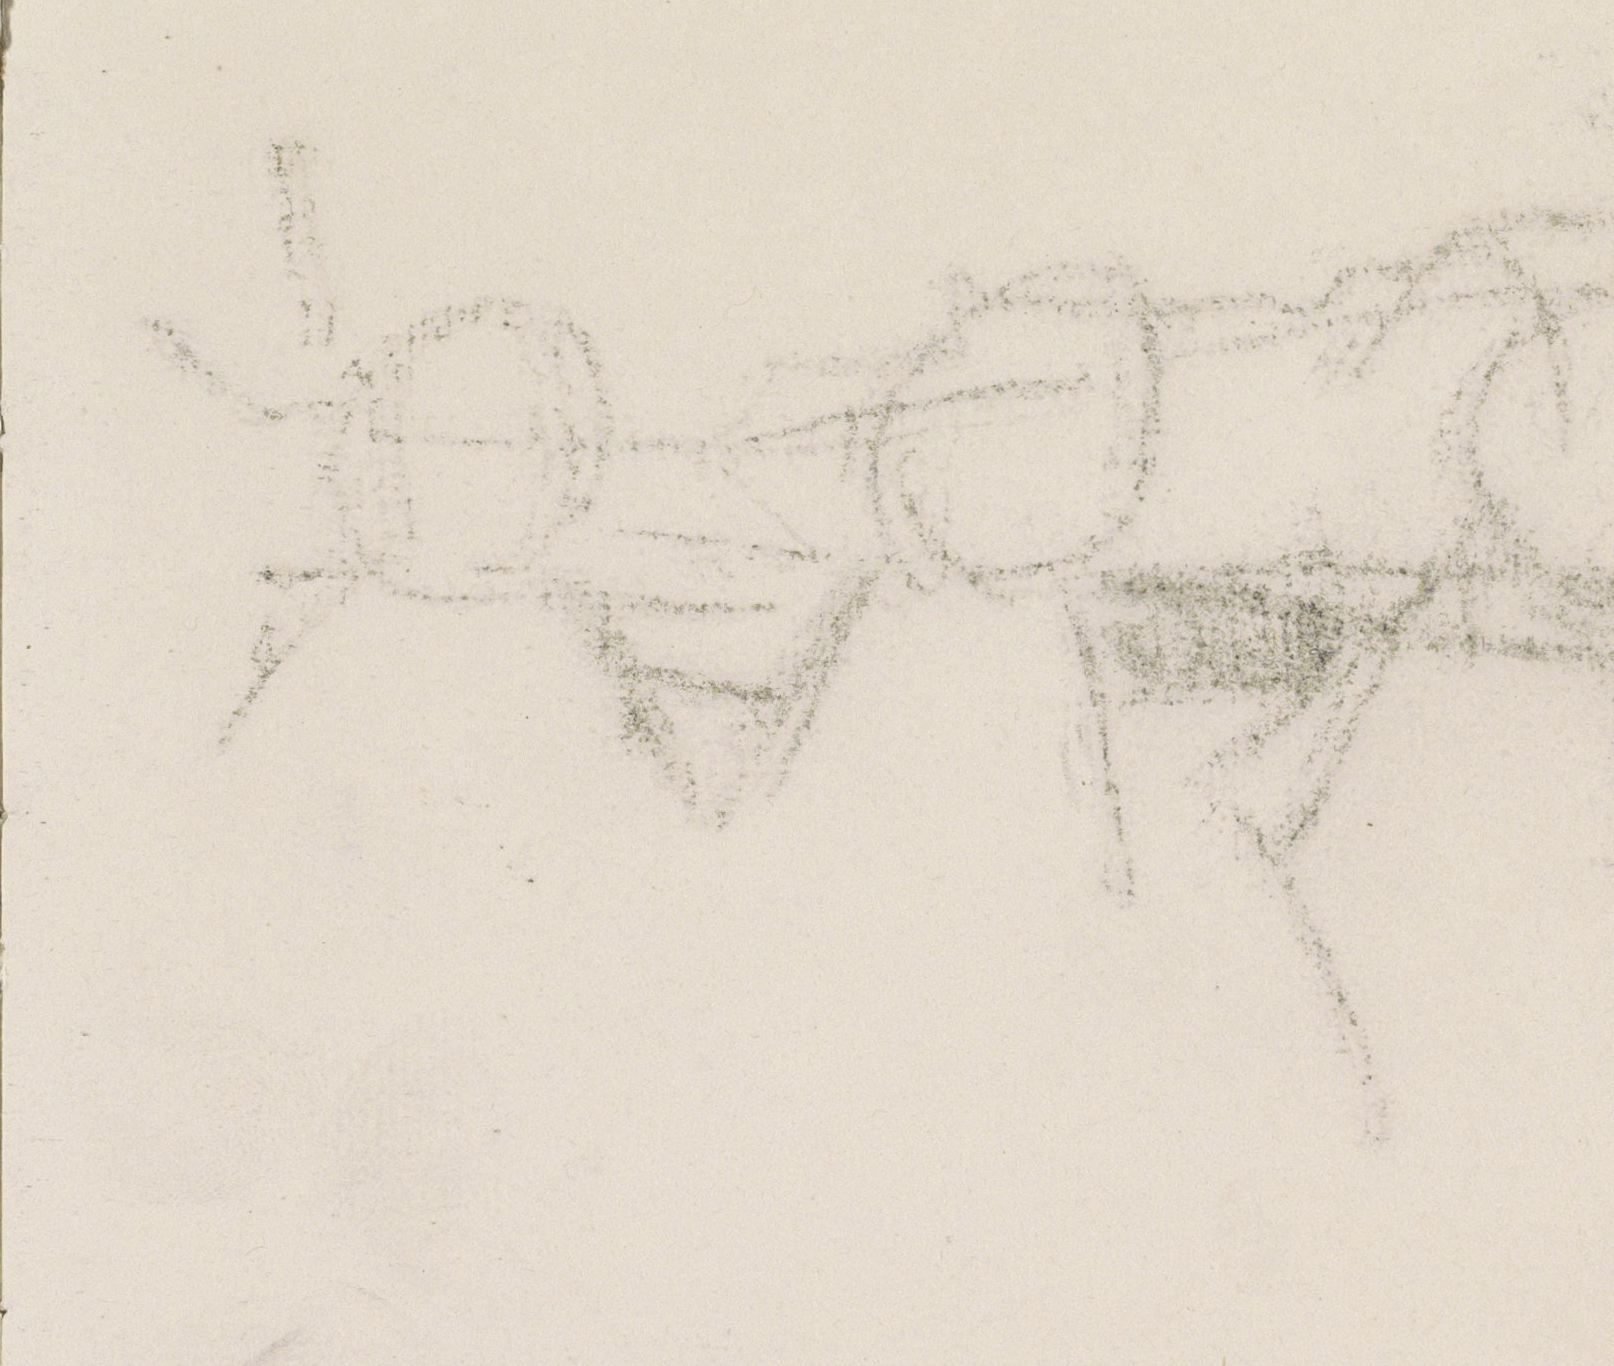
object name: sketchbook leaf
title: Abklatsch van de krijttekening op blad 10 verso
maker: isaac israels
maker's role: draughtsman, painter, print maker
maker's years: 1865-1934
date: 1886-1934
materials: paper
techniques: printmaking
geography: amsterdam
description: Blad 11 recto uit schetsboek LIV met 18 bladen.